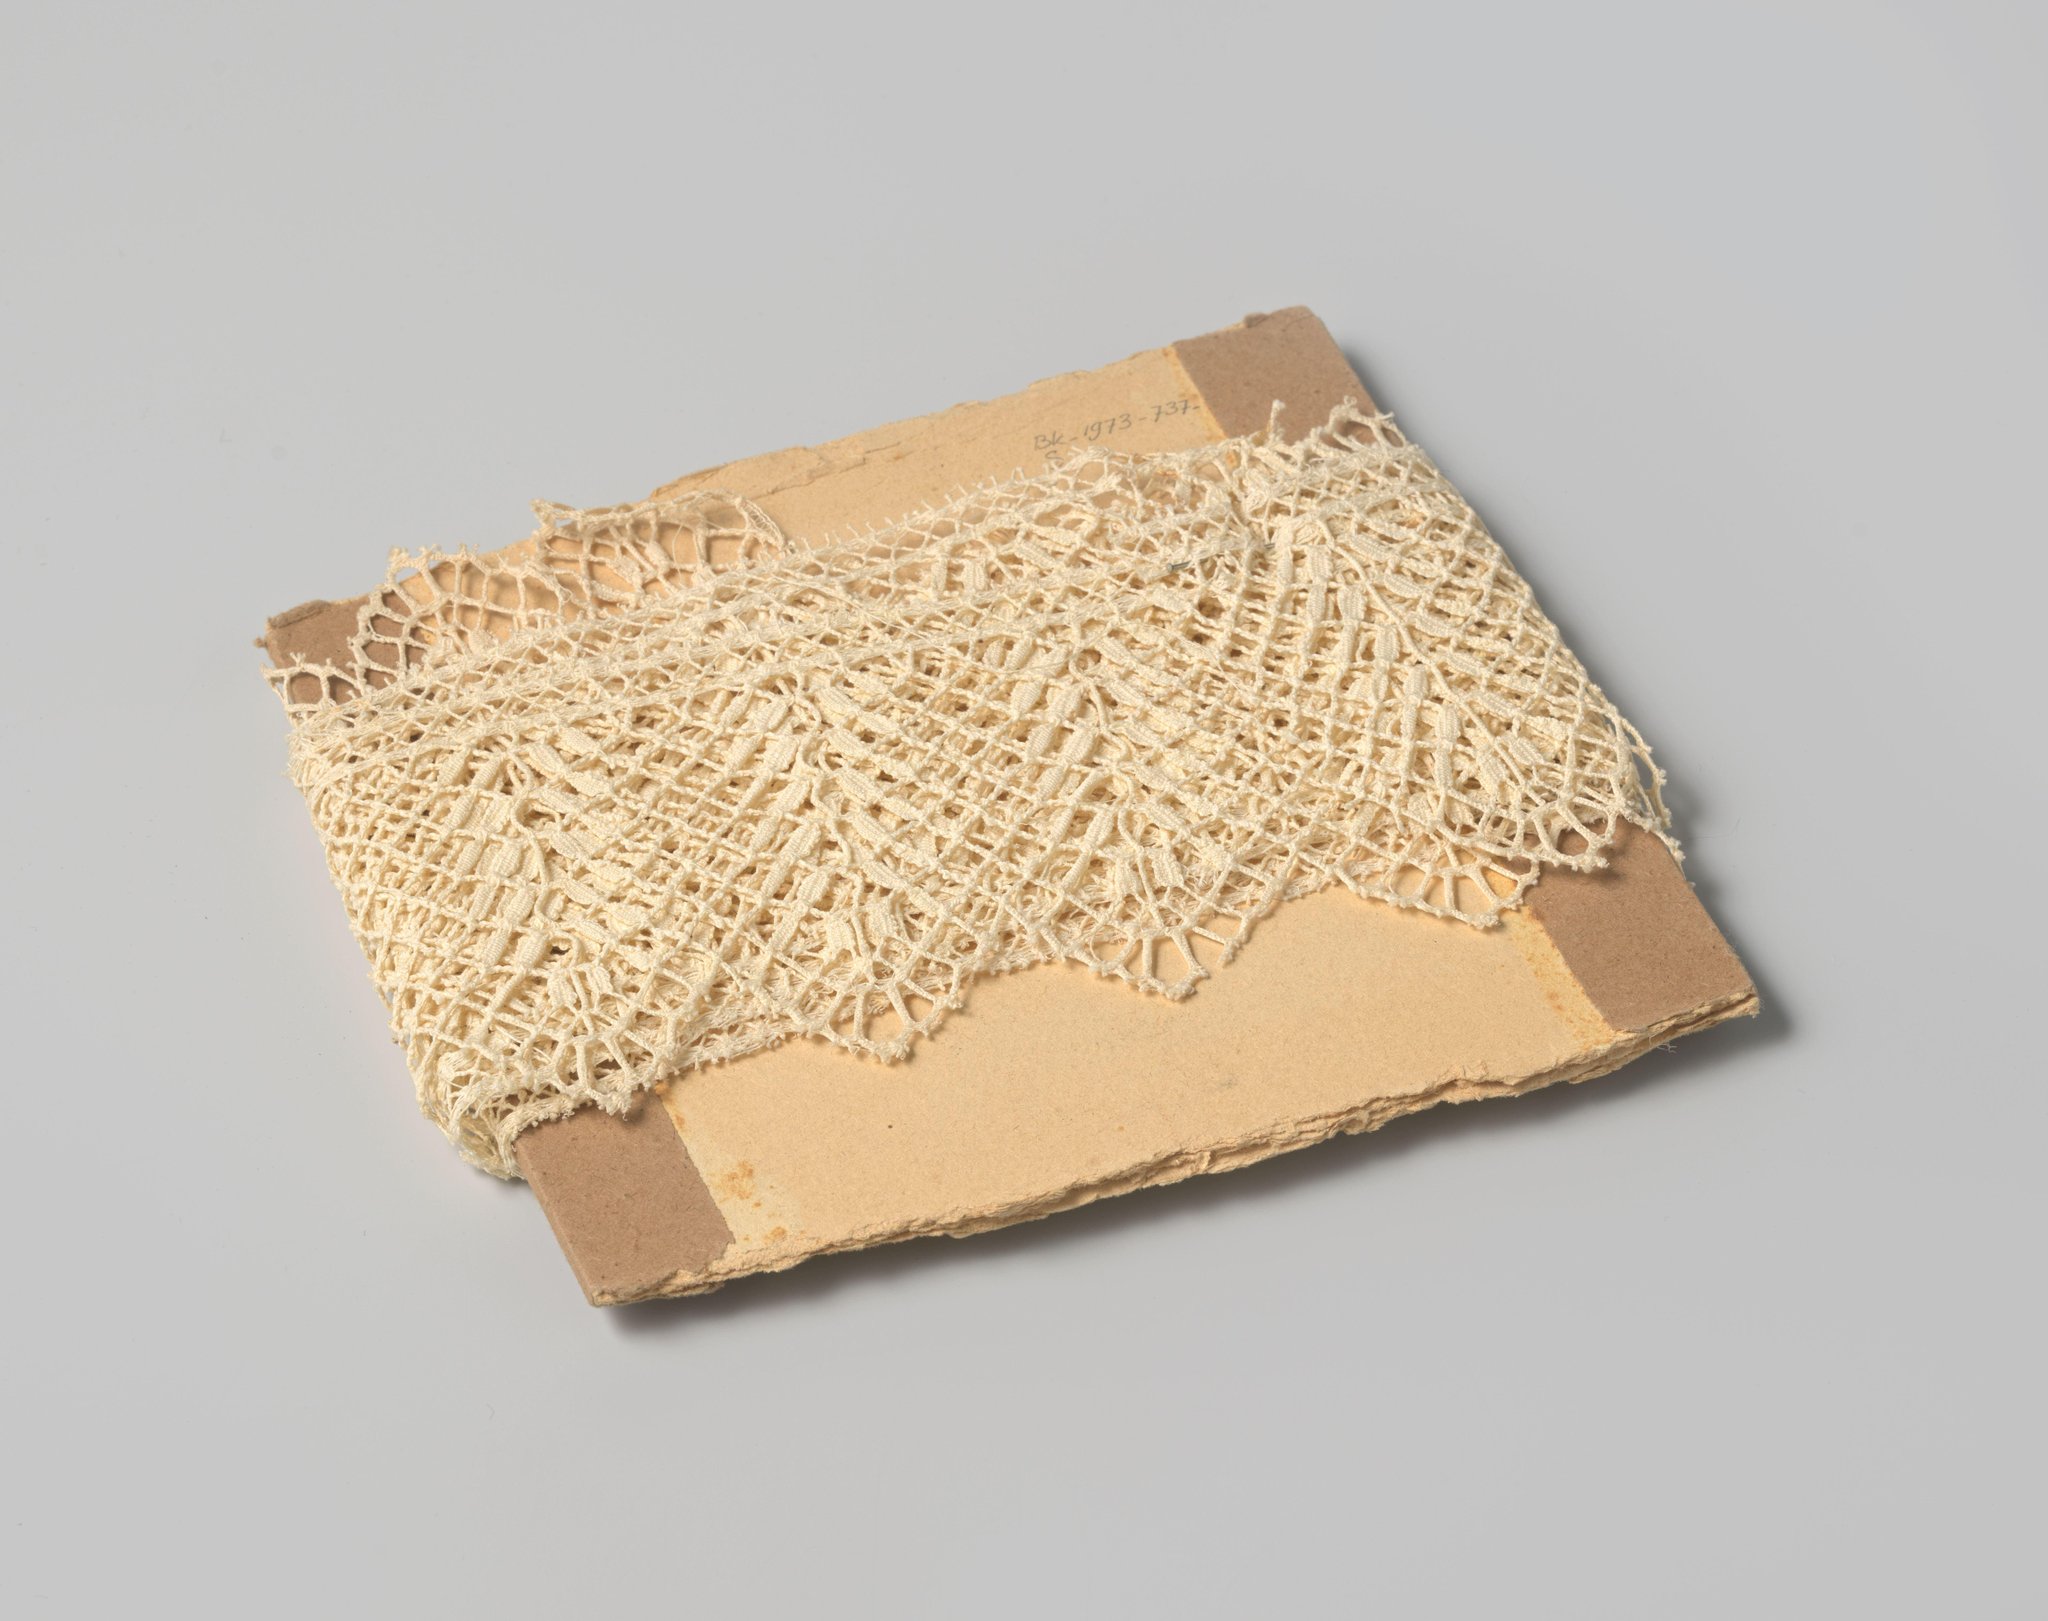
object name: strip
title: Strook witte etskant, getand en voorzien van picots, op karton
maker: gustav schnitzler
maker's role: paraplufabrikant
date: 1925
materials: cardboard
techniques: lace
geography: nijmegen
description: Metrages kant en passement, in wit en zwart en andere kleuren. Karton met creme guimpe-werk.